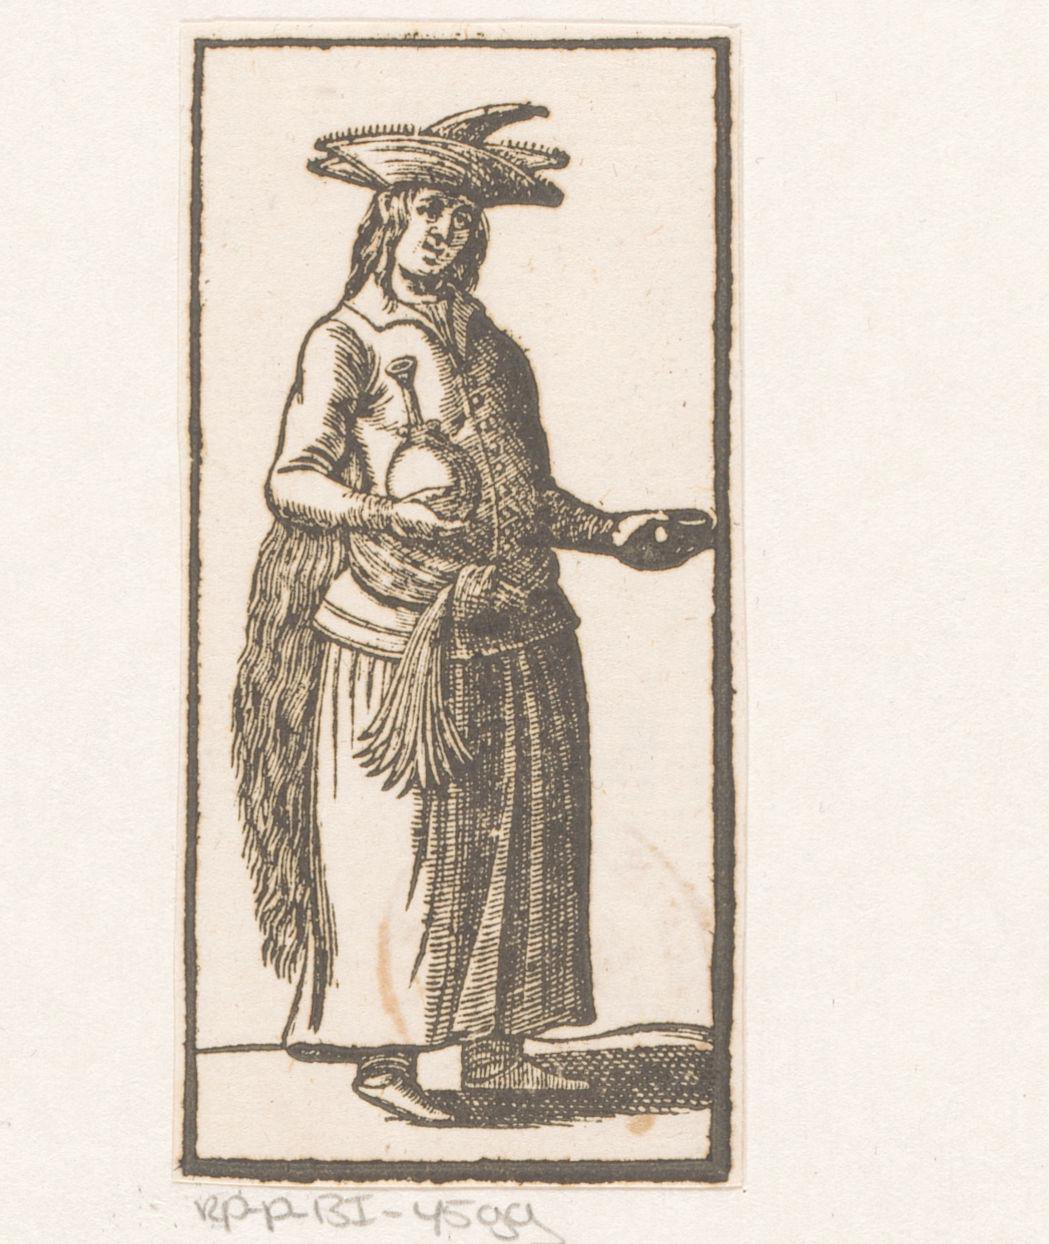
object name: print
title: Staande figuur met een hoed en een kruik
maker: Anonymous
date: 1600-1699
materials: paper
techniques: woodcut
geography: netherlands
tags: standing figure, head-gear, container of ceramics: jar, jug, pot, vase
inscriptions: collector's mark: Lugt 240